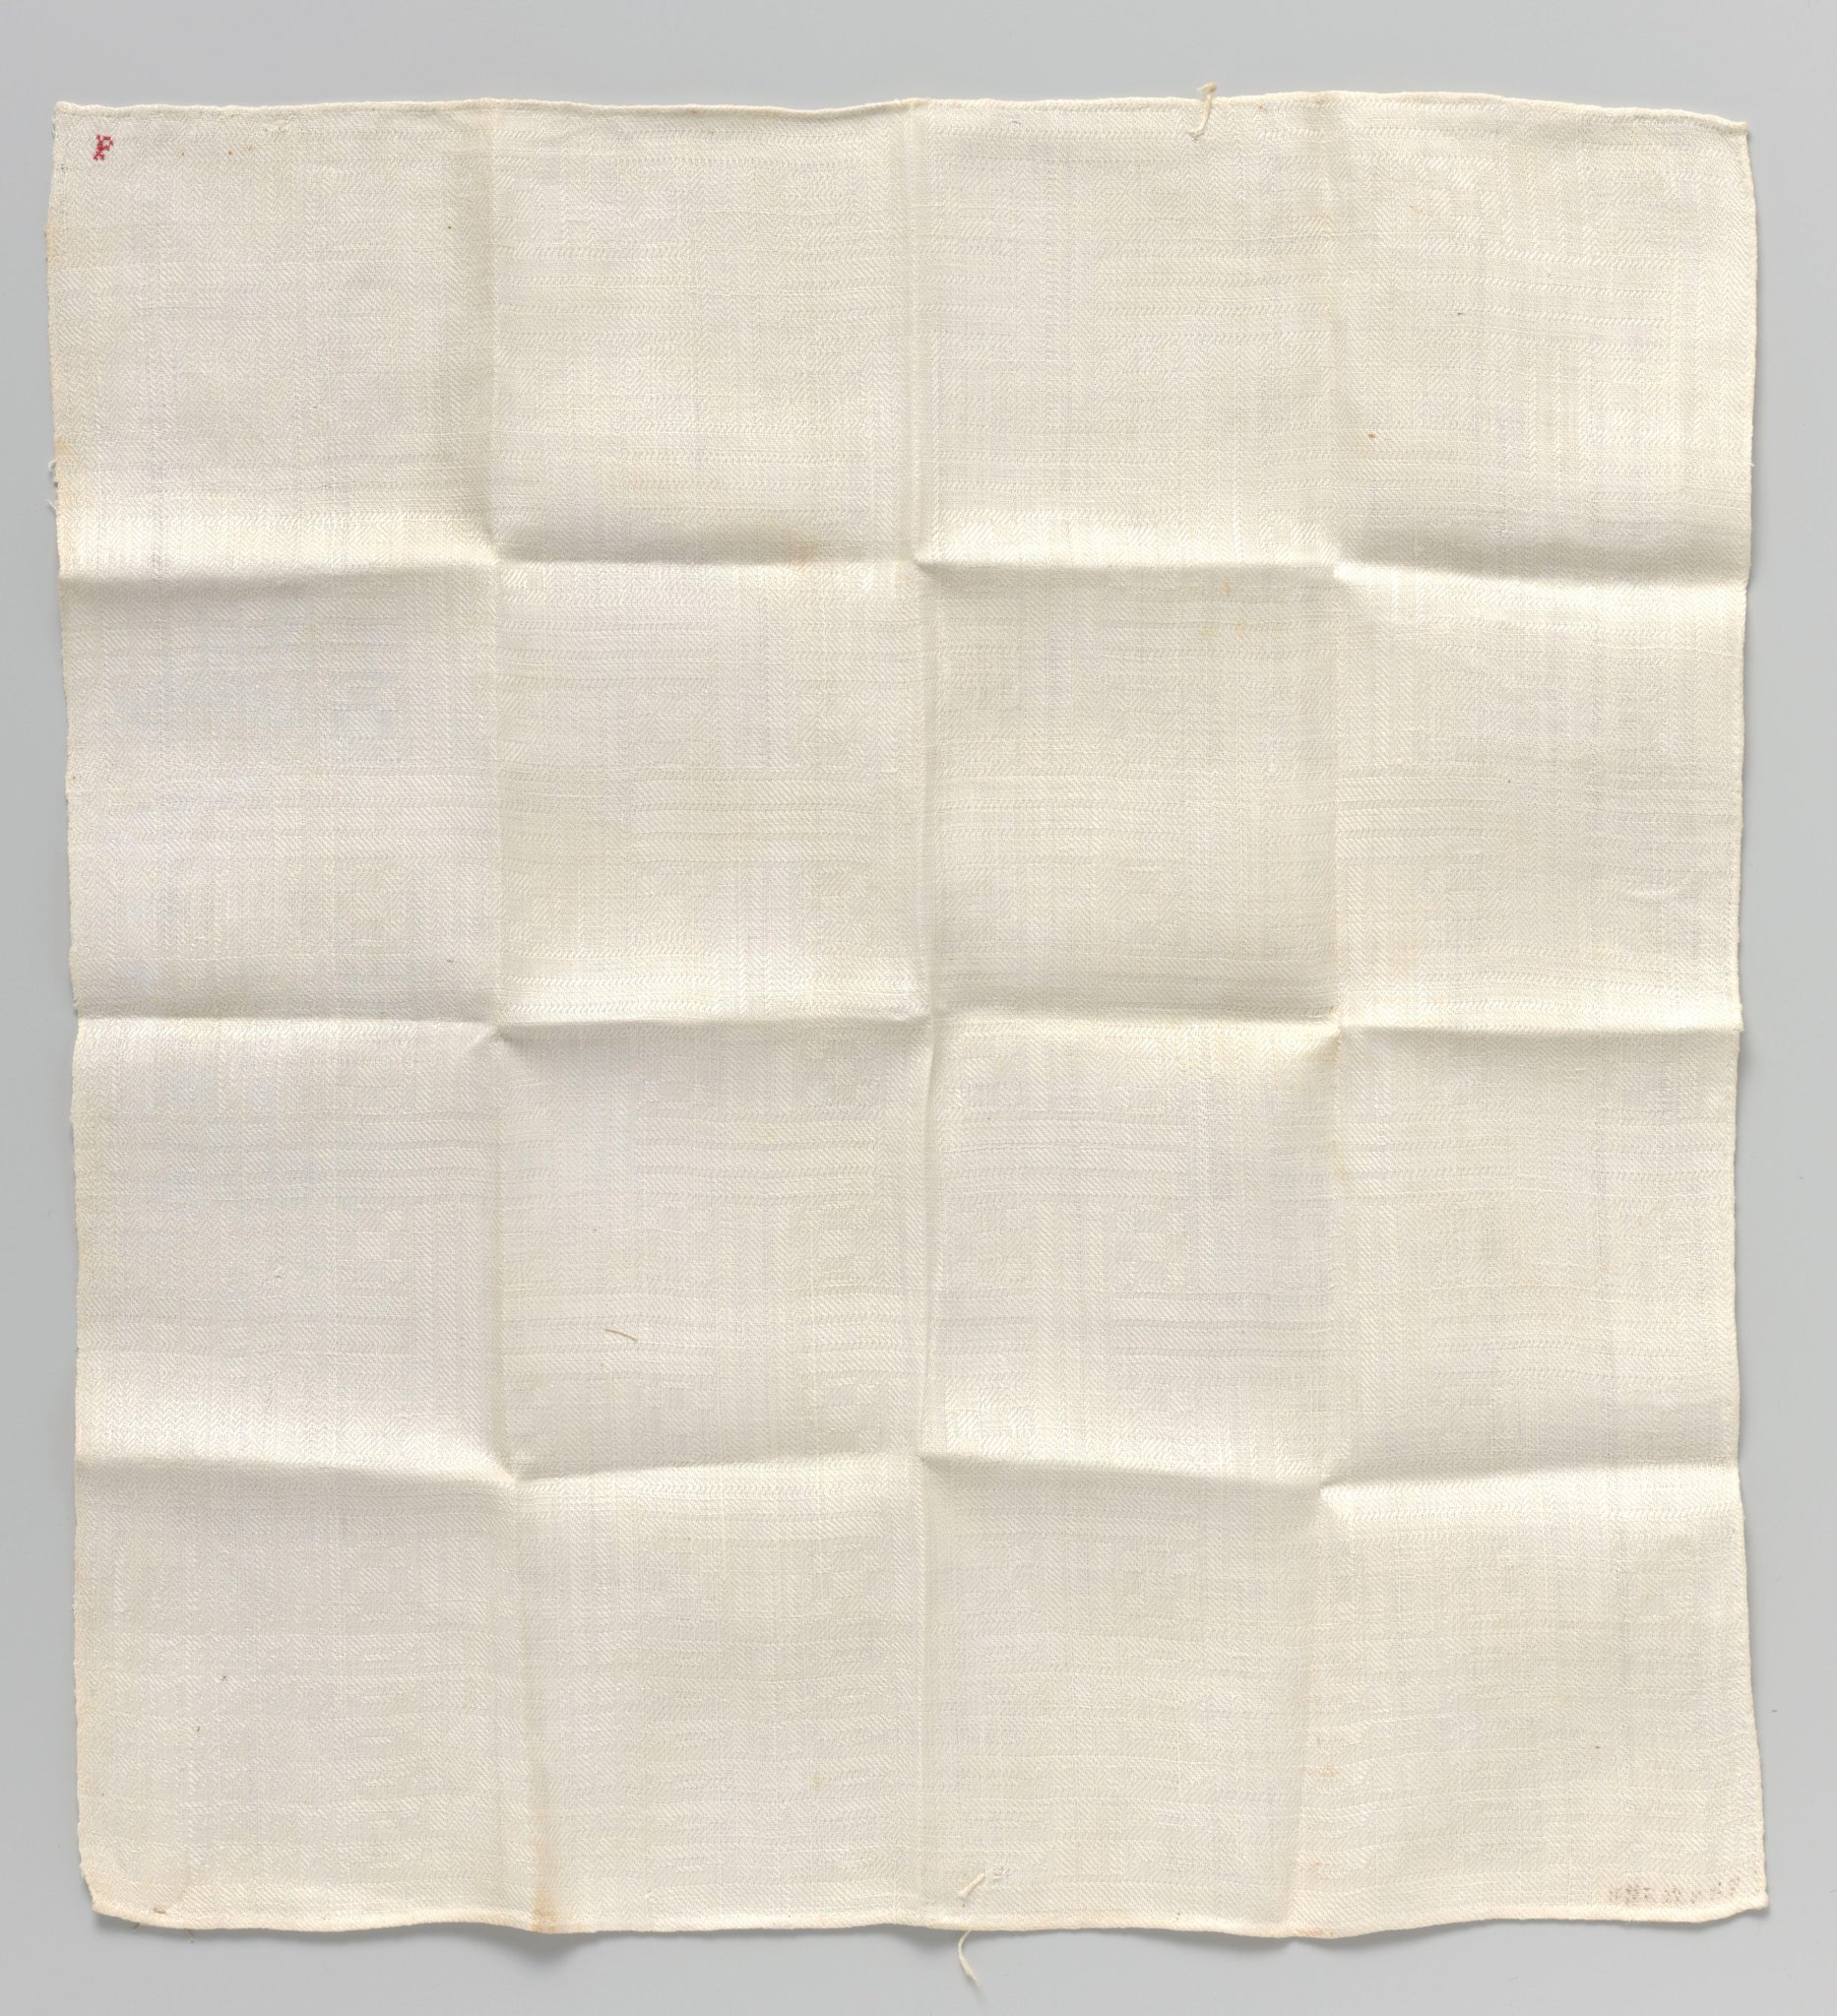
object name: napkin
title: Wit servet van damast met geometrisch patroon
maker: Anonymous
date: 1800-1930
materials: textile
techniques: damask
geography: europe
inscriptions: initials: ‘P’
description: BK-15446-13 t/m 16 en BK-2021-152 hebben hetzelfde ingeweven geometrische patroon.